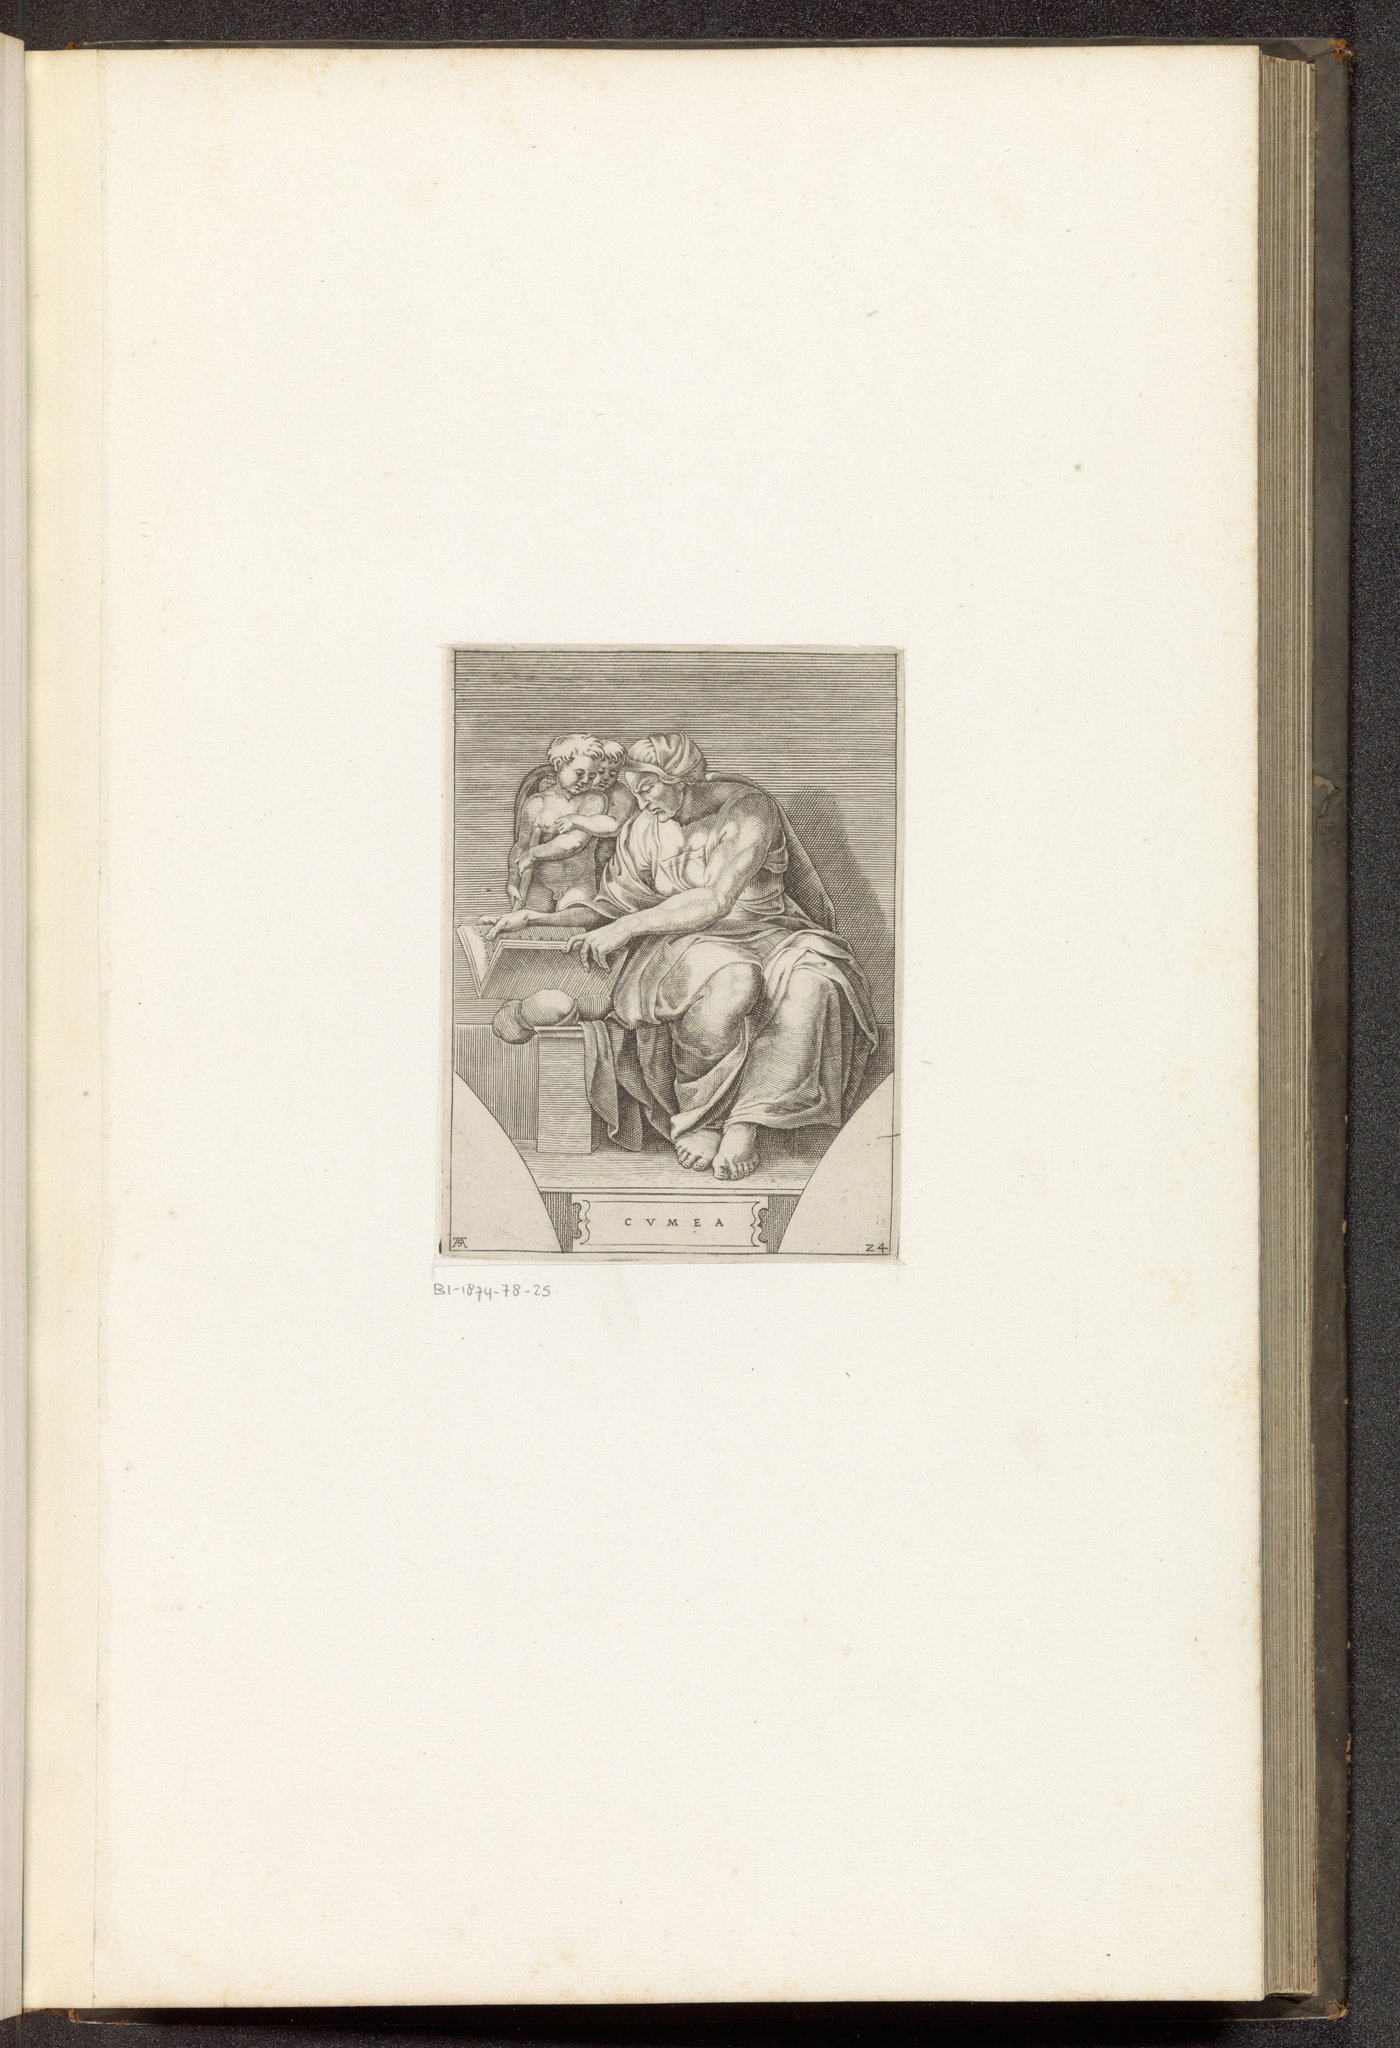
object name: album leaf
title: Sibille van Cumae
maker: adamo scultori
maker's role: painter, print maker, sculptor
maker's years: 1530-1585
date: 1585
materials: paper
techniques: engraving, intaglio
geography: italy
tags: cumaean sibyl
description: De Sibille van Cumae, zittend met een opengeslagen boek. Naast de Sibille twee kleine figuren waarvan één met een boek onder de arm. Eén van de Sibillen van Michelangelo's plafondschildering. Titel in ondermarge en genummerd rechtsonder: 24. De prent maakt deel uit van een album.